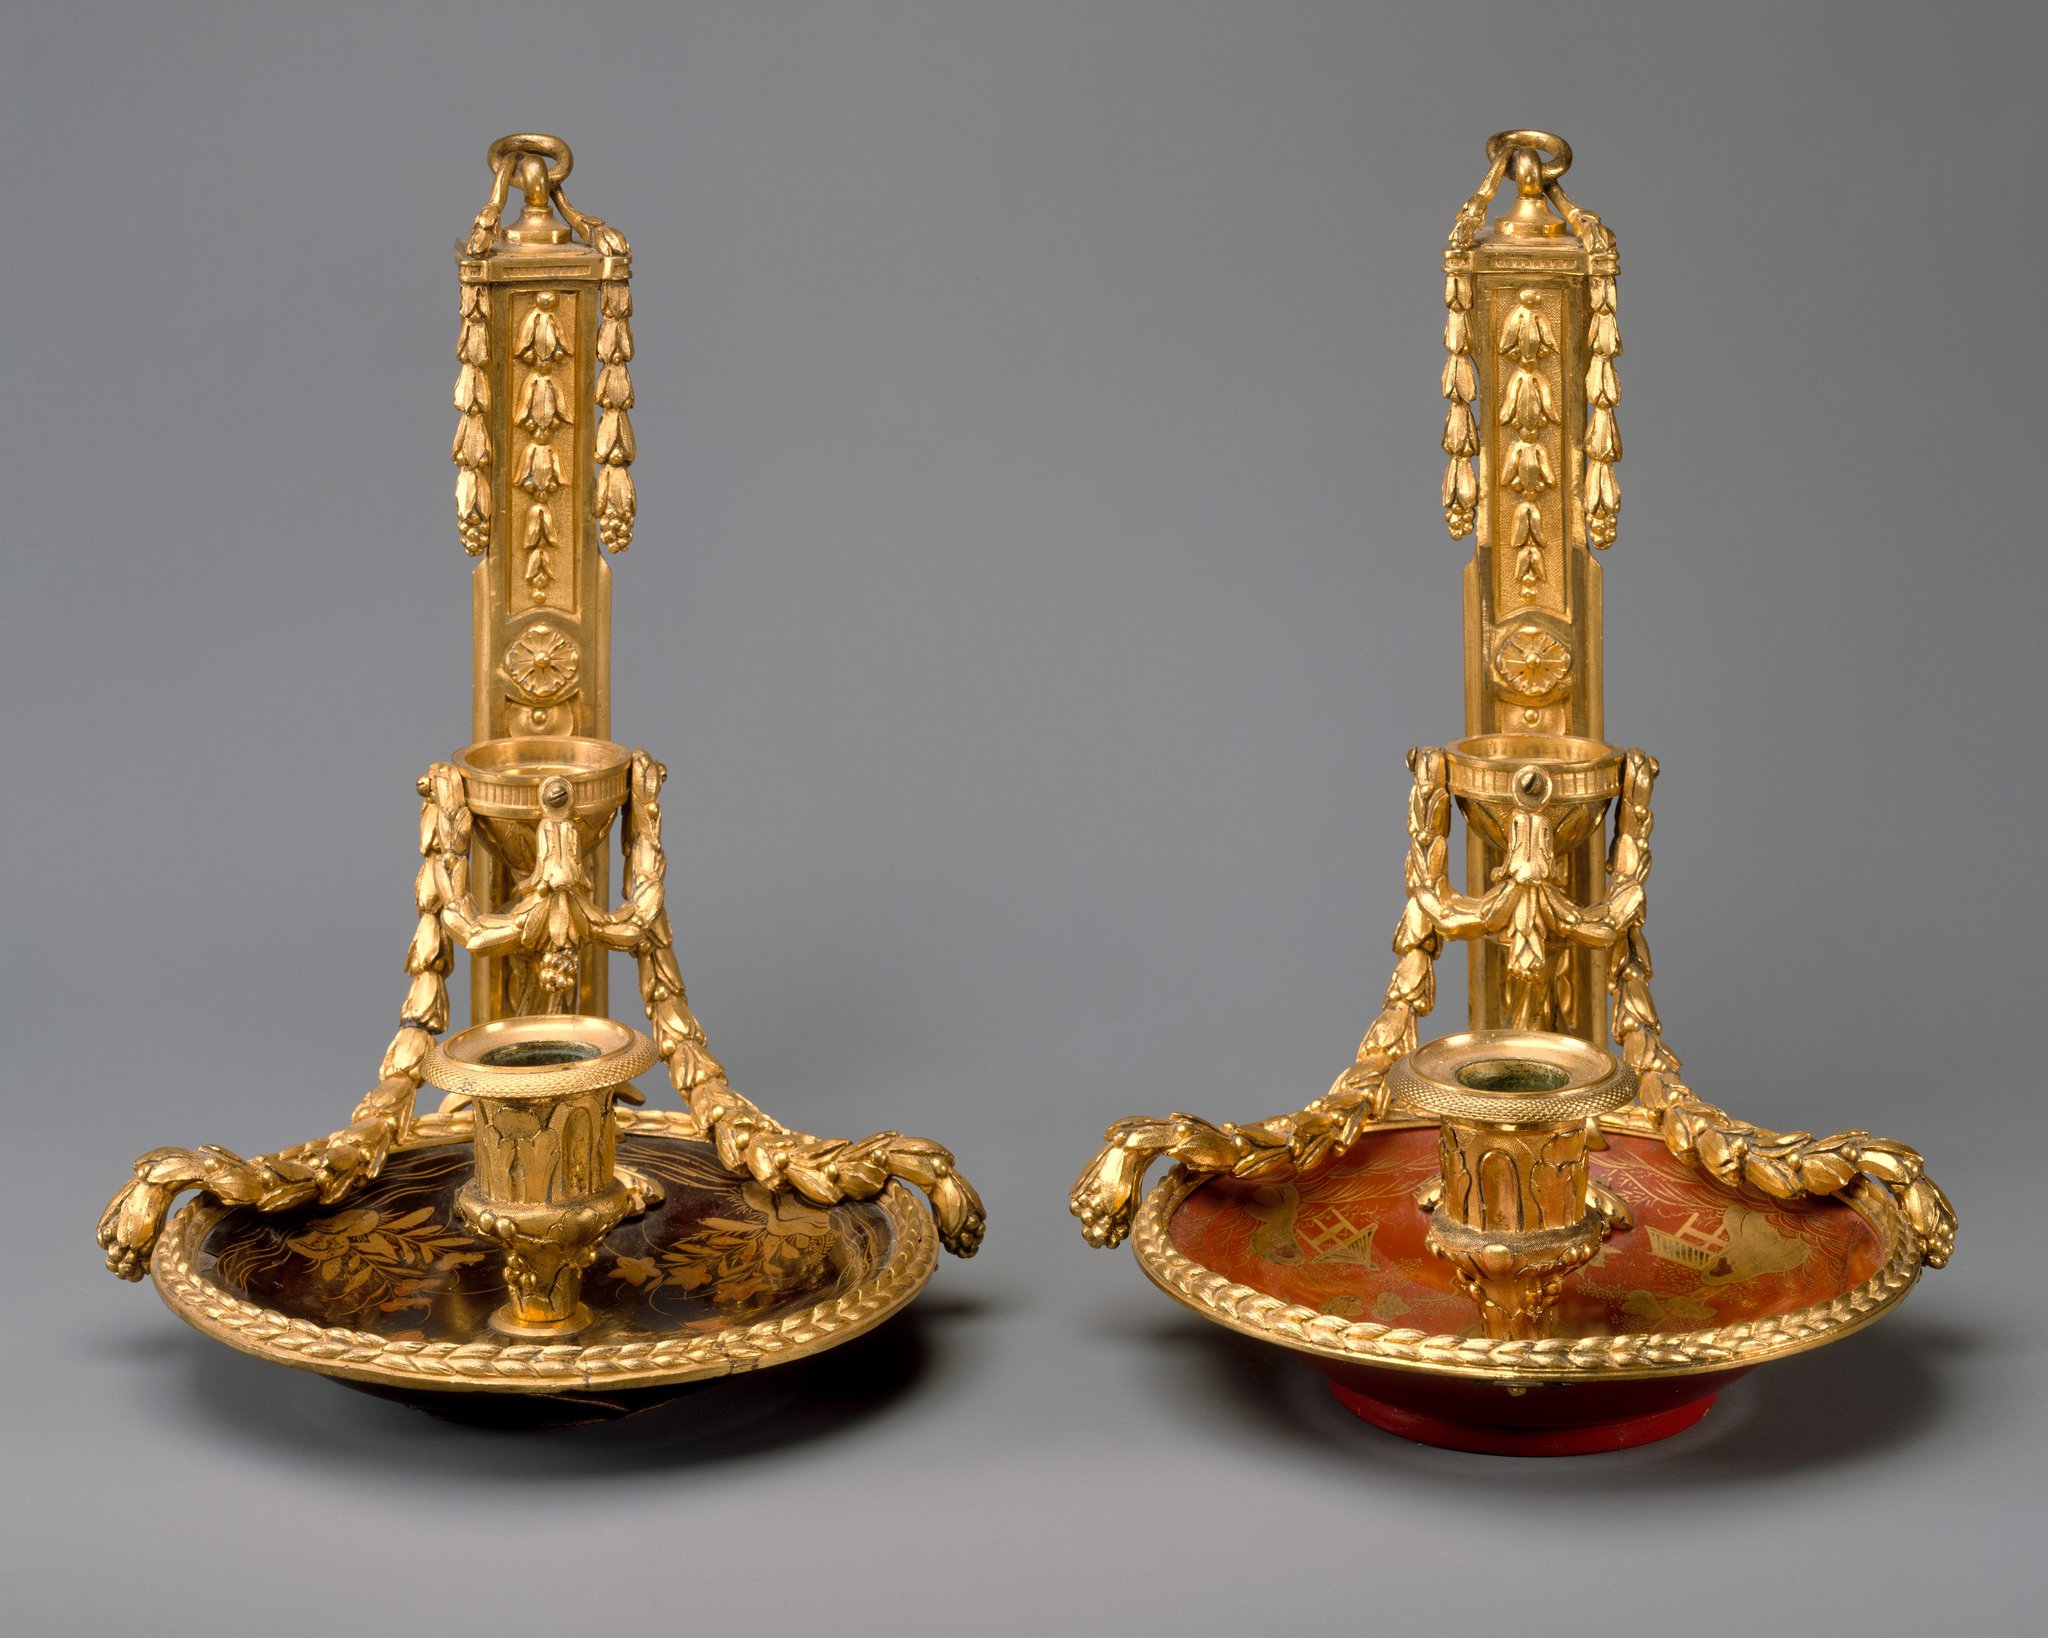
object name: candlestick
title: Pair of candlesticks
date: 1770-1780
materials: gilt bronze, lacquer